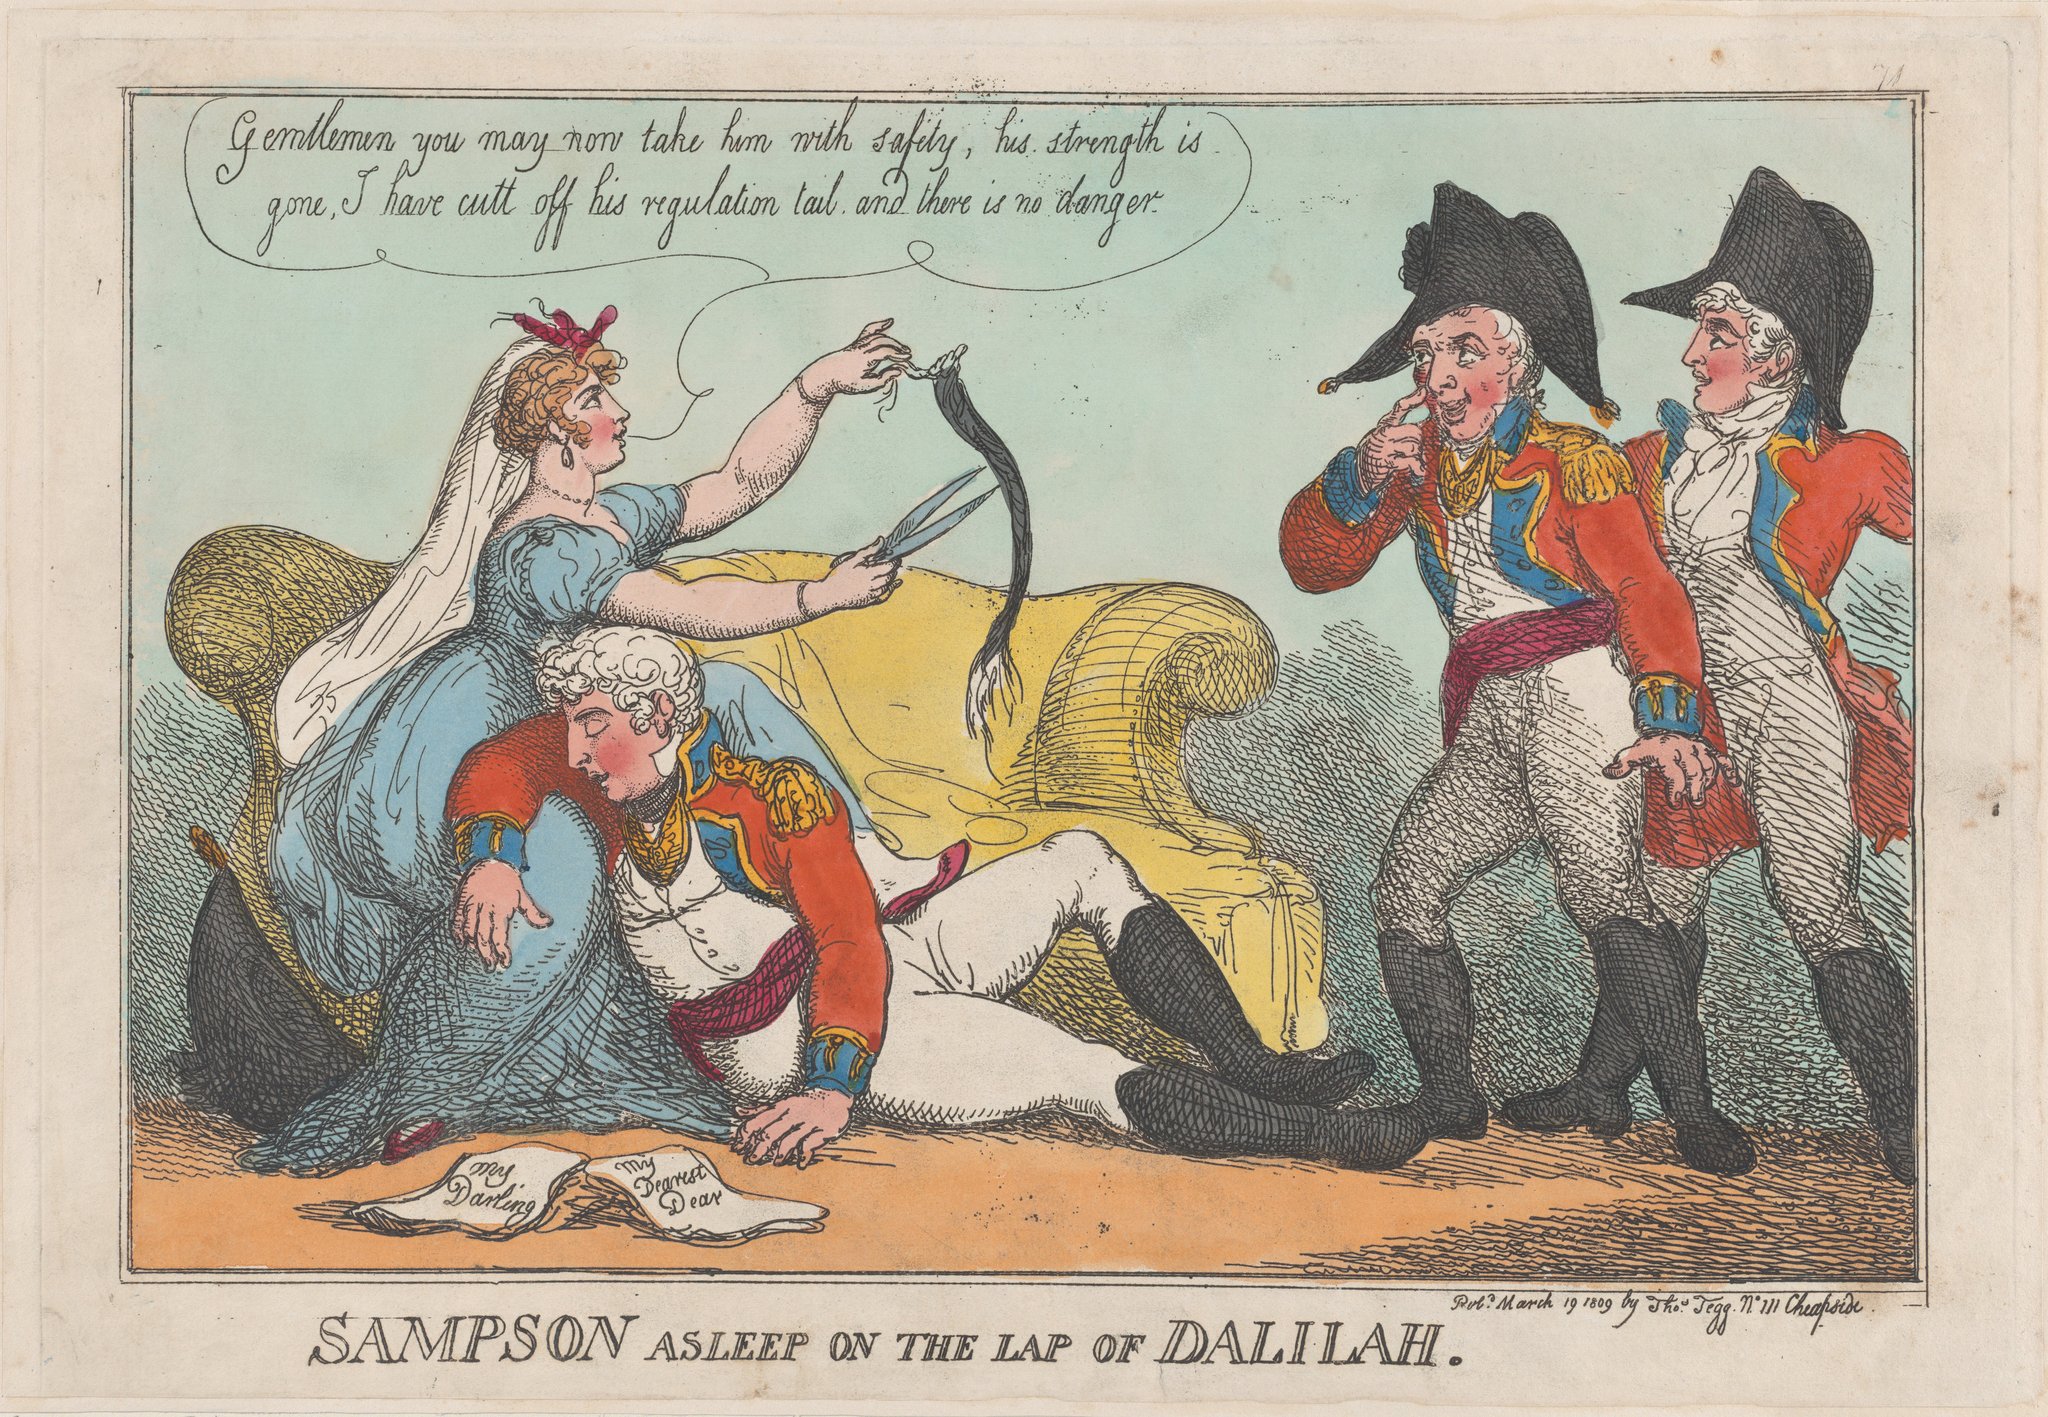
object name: print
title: Sampson Asleep on the Lap of Dalilah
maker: thomas rowlandson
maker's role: artist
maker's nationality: british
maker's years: 1757-1827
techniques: etching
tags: satire,soldiers,men,women,politics